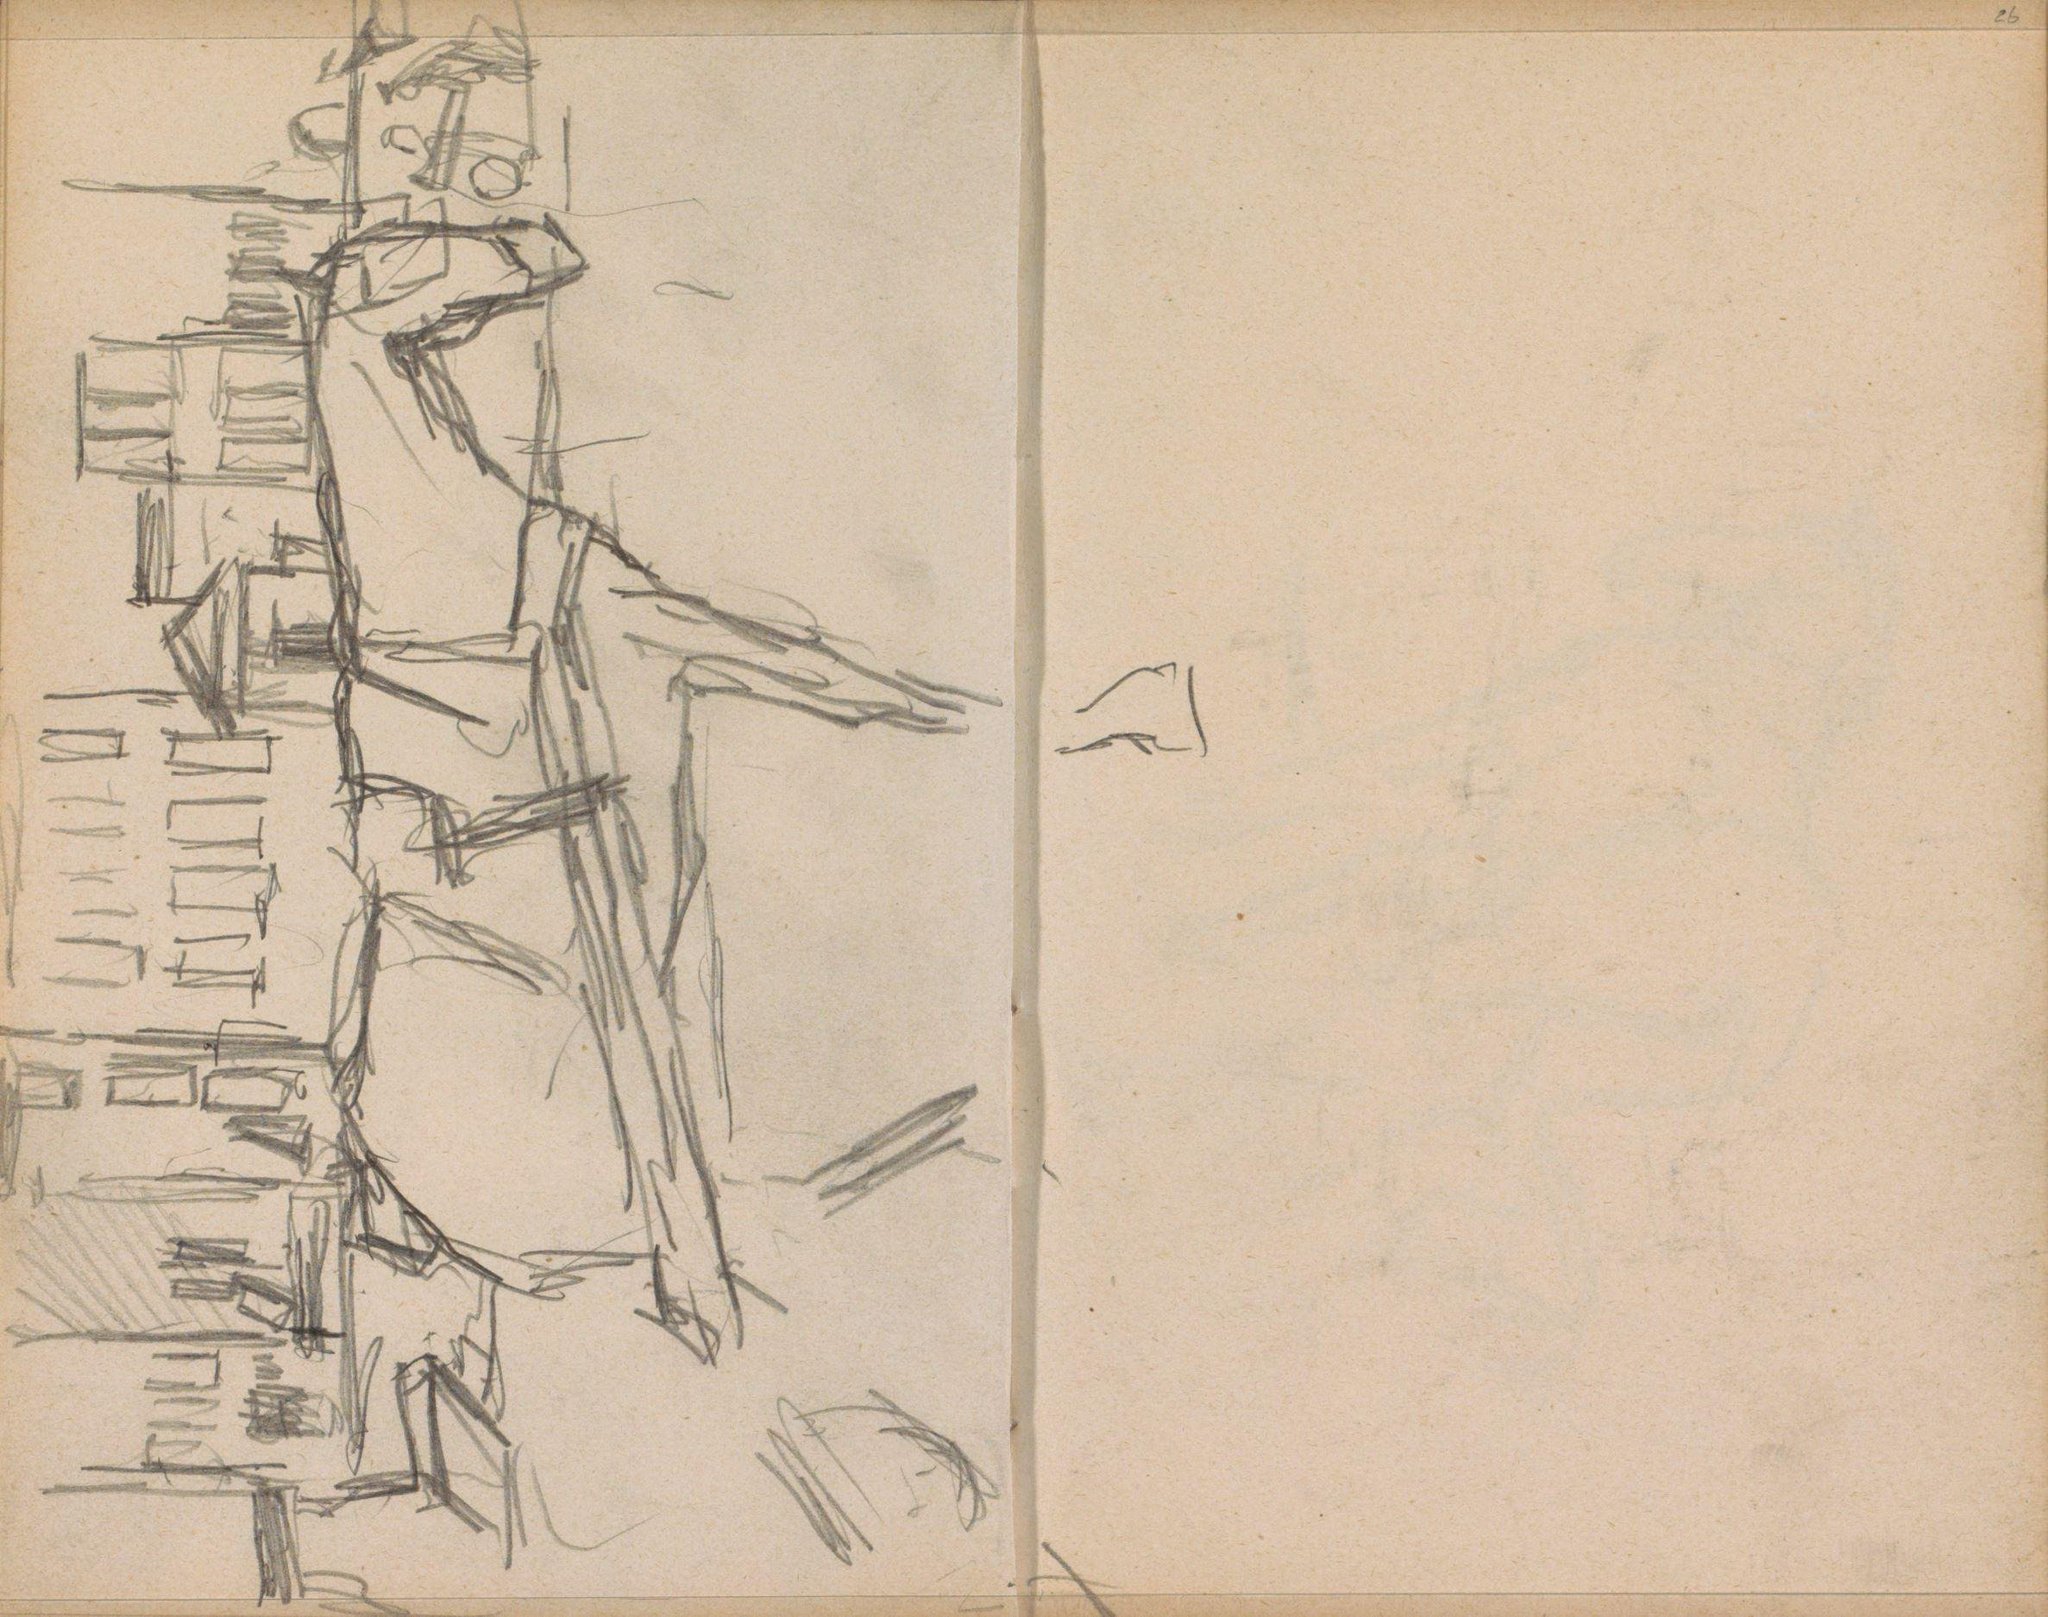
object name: sketchbook leaf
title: Gezicht in Amsterdam met een aangespannen paard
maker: george hendrik breitner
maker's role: draughtsman, painter, print maker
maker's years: 1857-1923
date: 1886-1903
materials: paper, pencil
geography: amsterdam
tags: four-wheeled vehicle drawn by one animal, urban housing, horse, amsterdam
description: Pagina 25 en pagina 26 uit een schetsboek met 46 bladen.